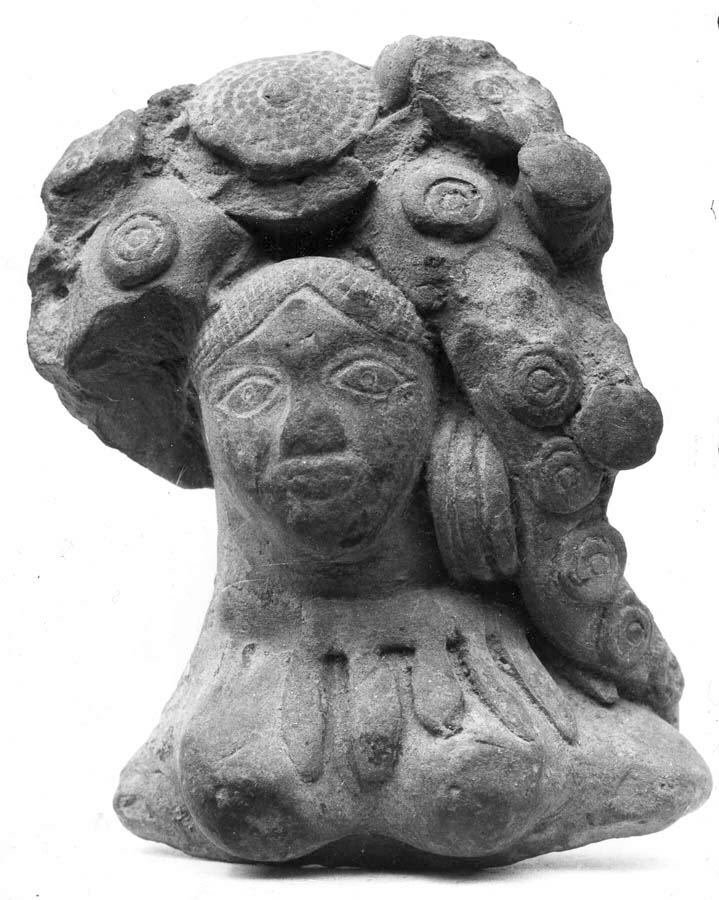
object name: bust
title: Bust of a Female Deity (Yakshi?)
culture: indian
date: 300-101 BCE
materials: clay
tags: maurya,mauryan